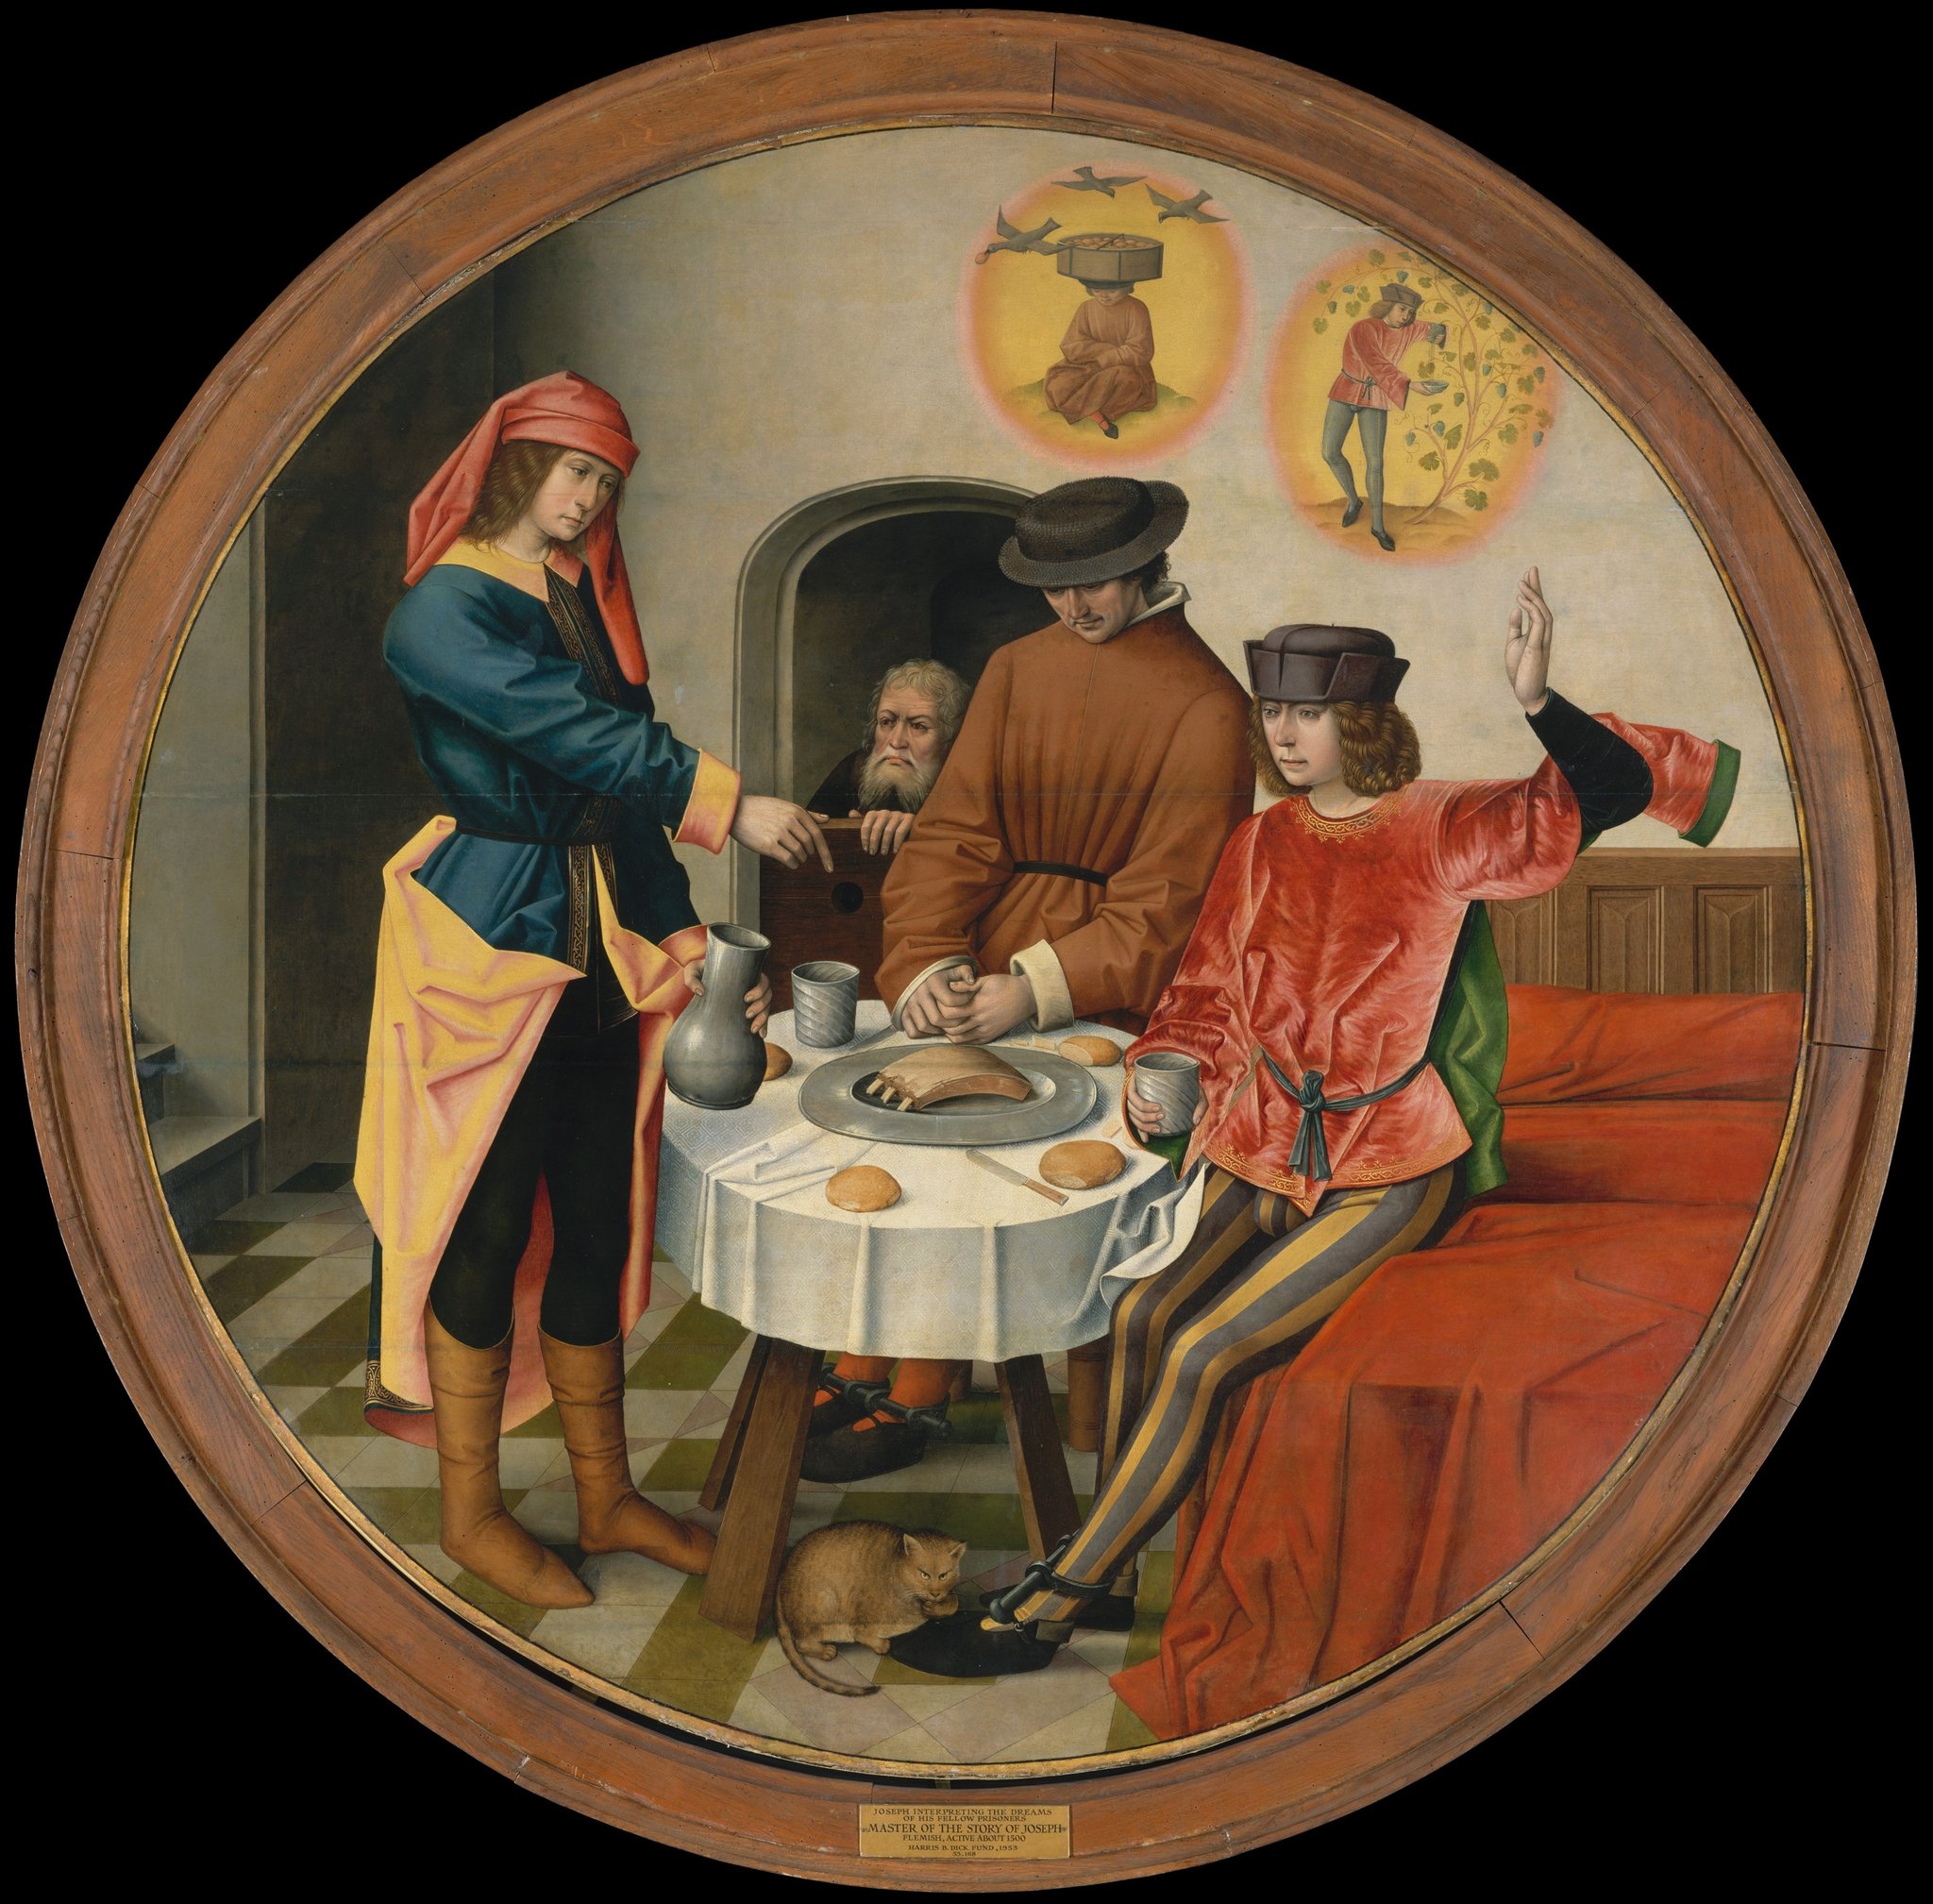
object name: painting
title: Joseph Interpreting the Dreams of His Fellow Prisoners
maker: master of the story of joseph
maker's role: artist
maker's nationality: netherlandish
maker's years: 1490-1510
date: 1495-1505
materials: oil, wood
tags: food,bedrooms,prisoners,men,cats